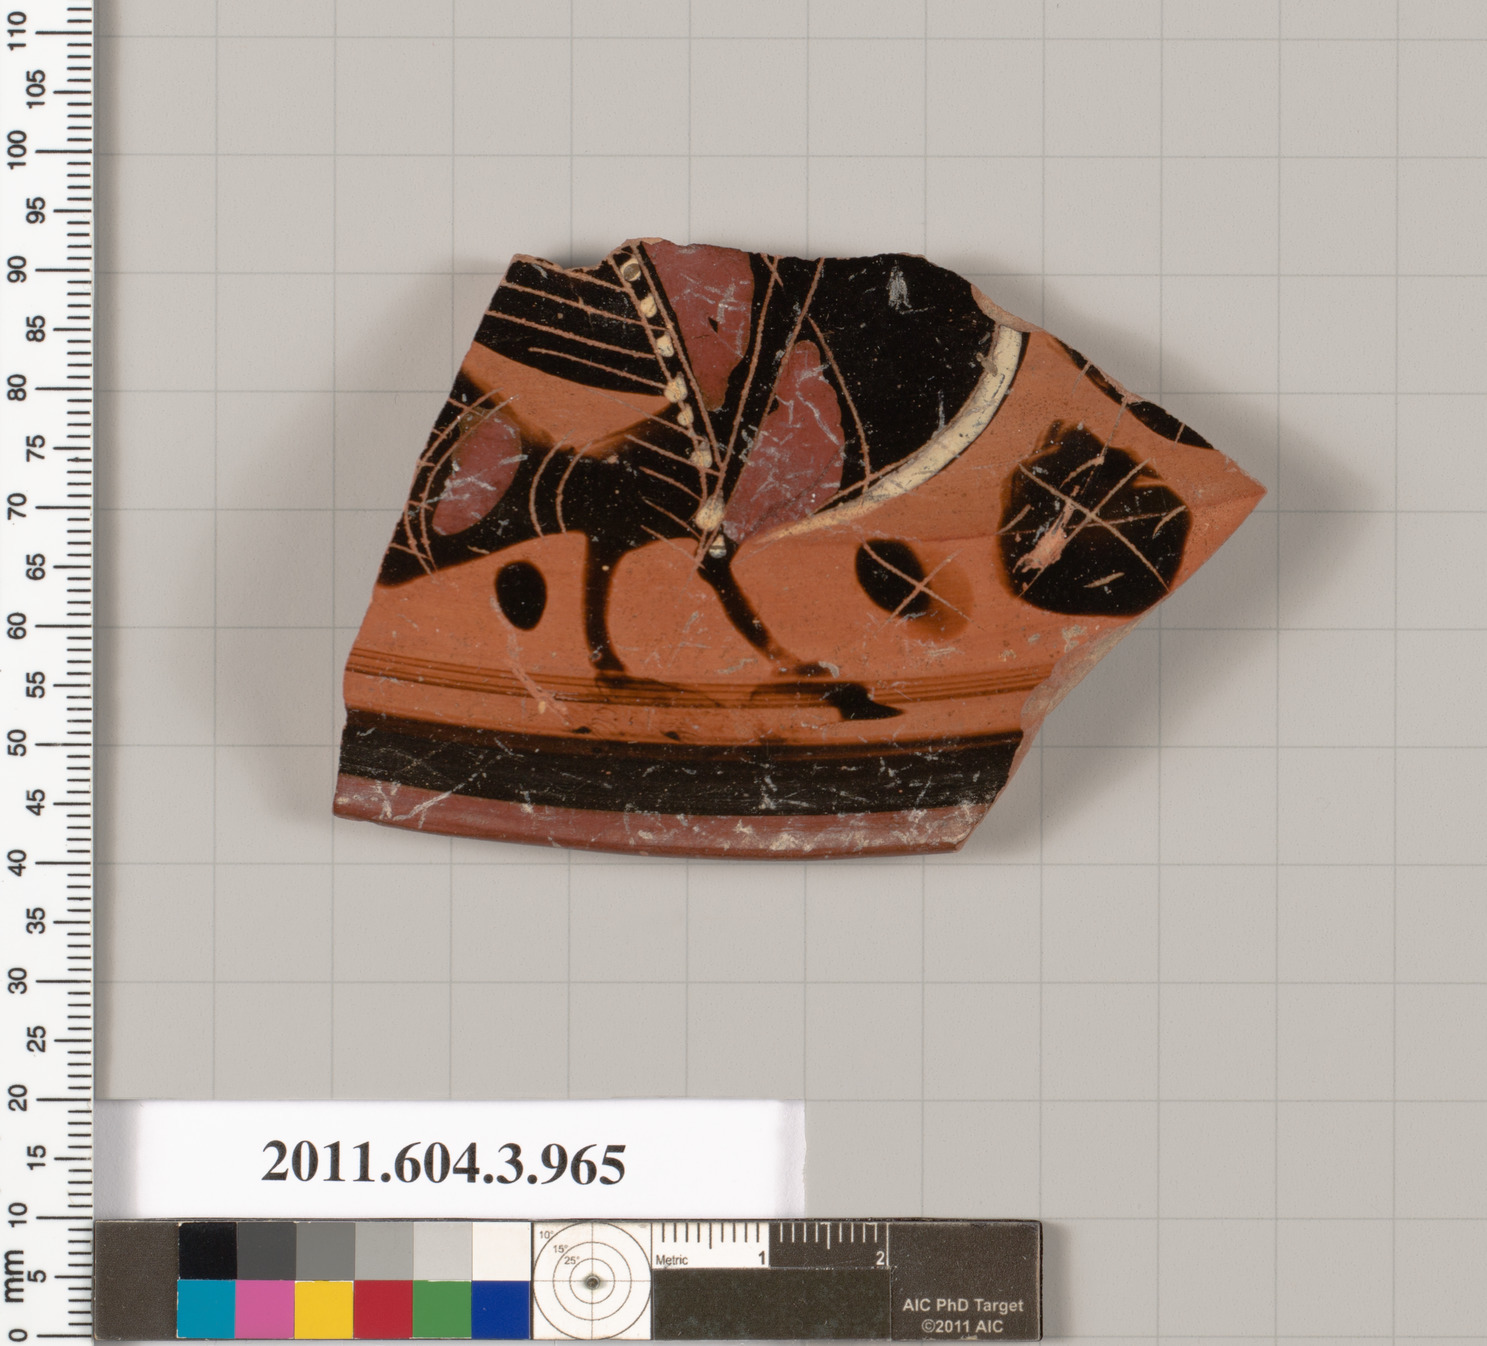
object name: lekanis lid fragment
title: Terracotta fragment of a lekanis lid (covered dish)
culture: greek, attic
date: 575-551 BCE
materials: terracotta